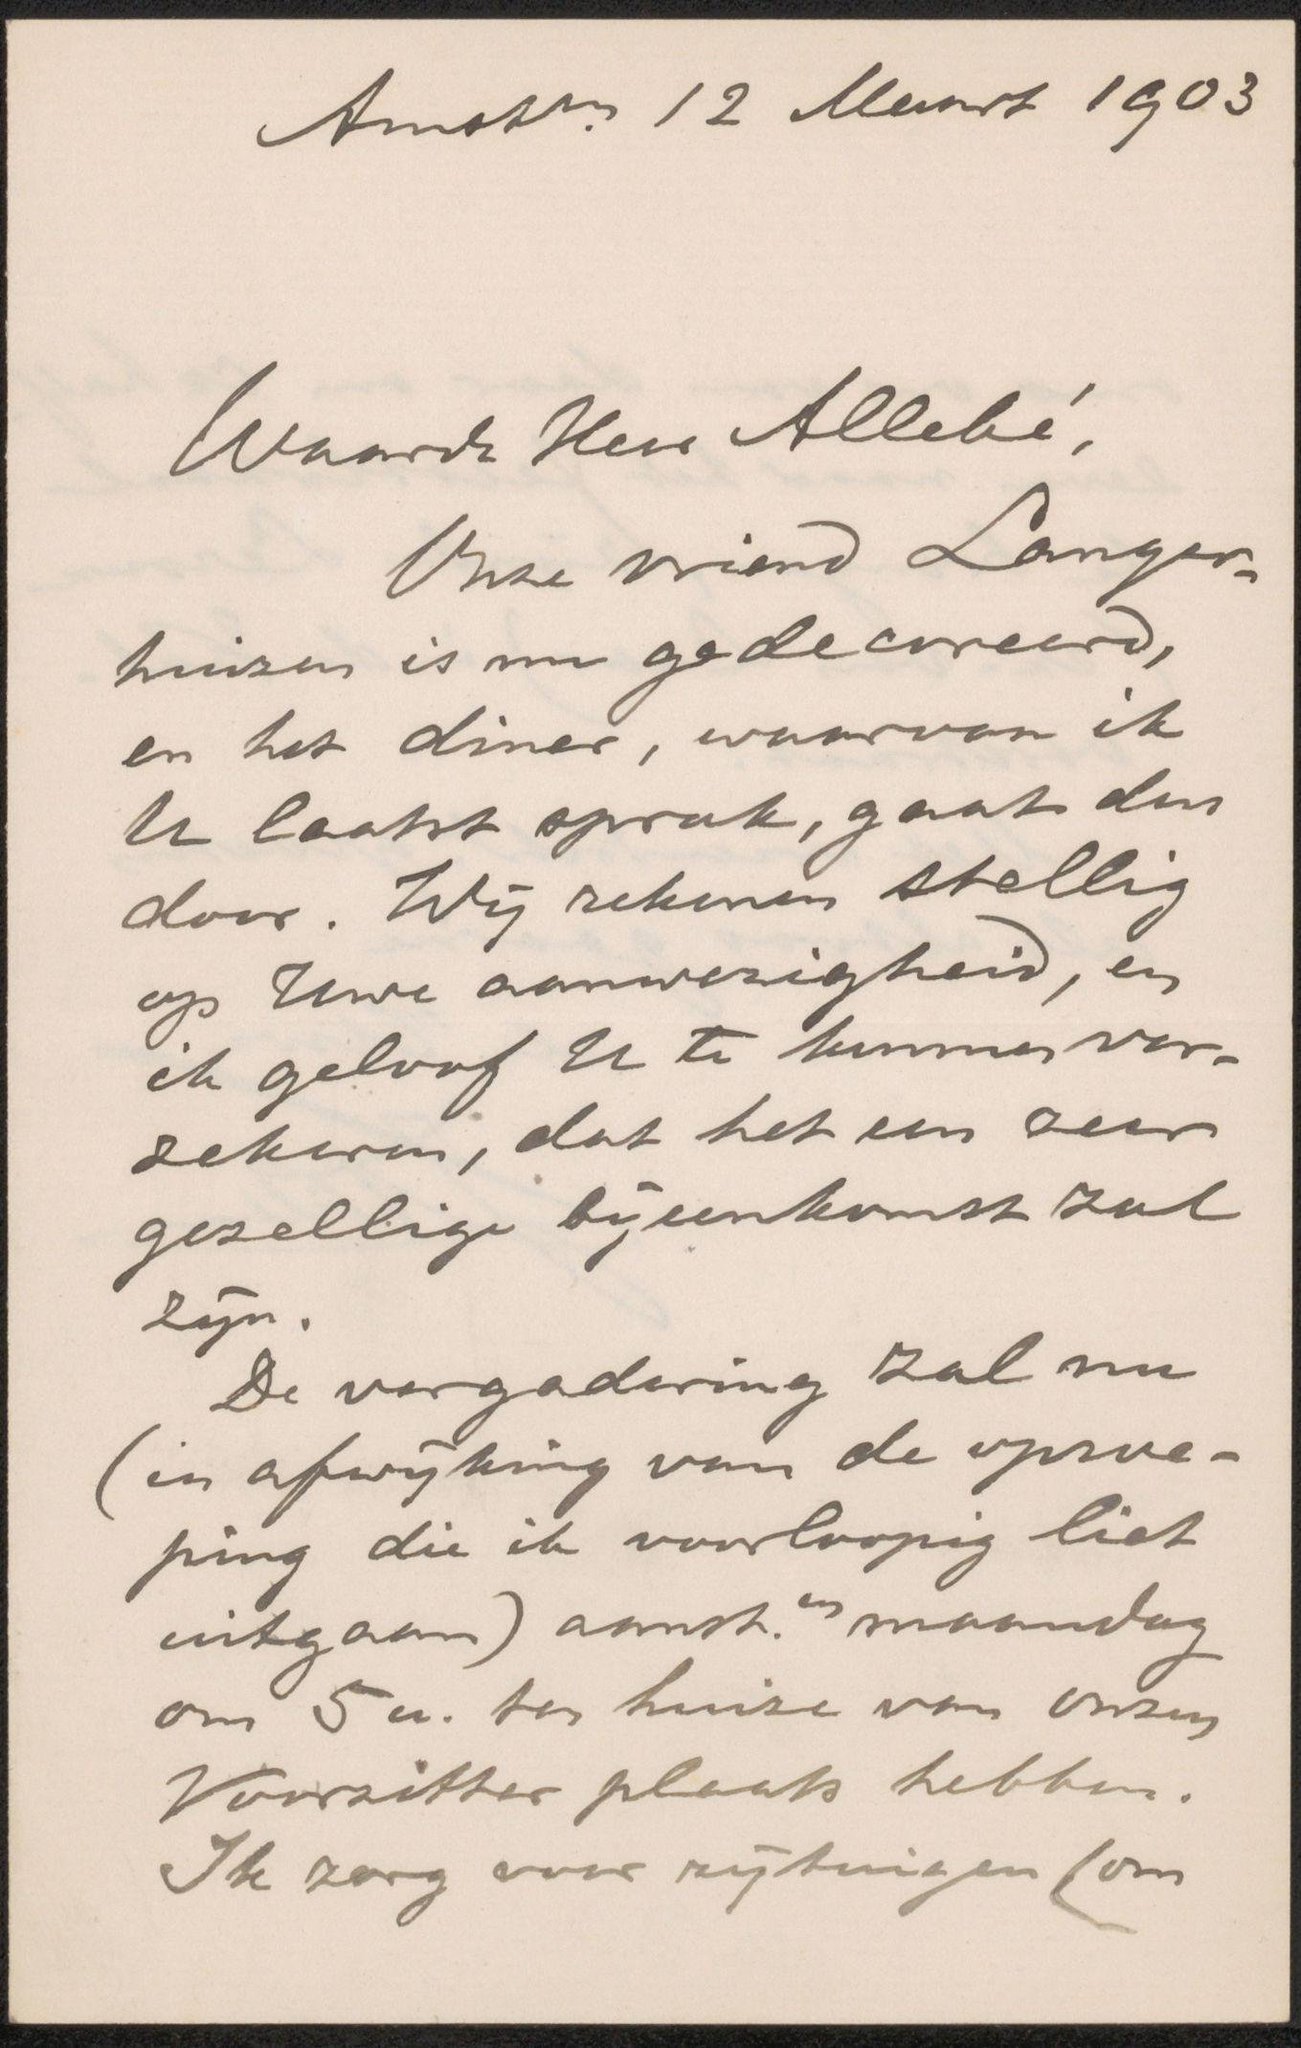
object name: letter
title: Brief aan August Allebé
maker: jérôme alexander sillem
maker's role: politician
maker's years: 1840-1912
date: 1903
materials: ink, paper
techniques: pen, writing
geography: amsterdam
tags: mayor, amsterdam, print maker, draughtsman, august allebé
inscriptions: watermark